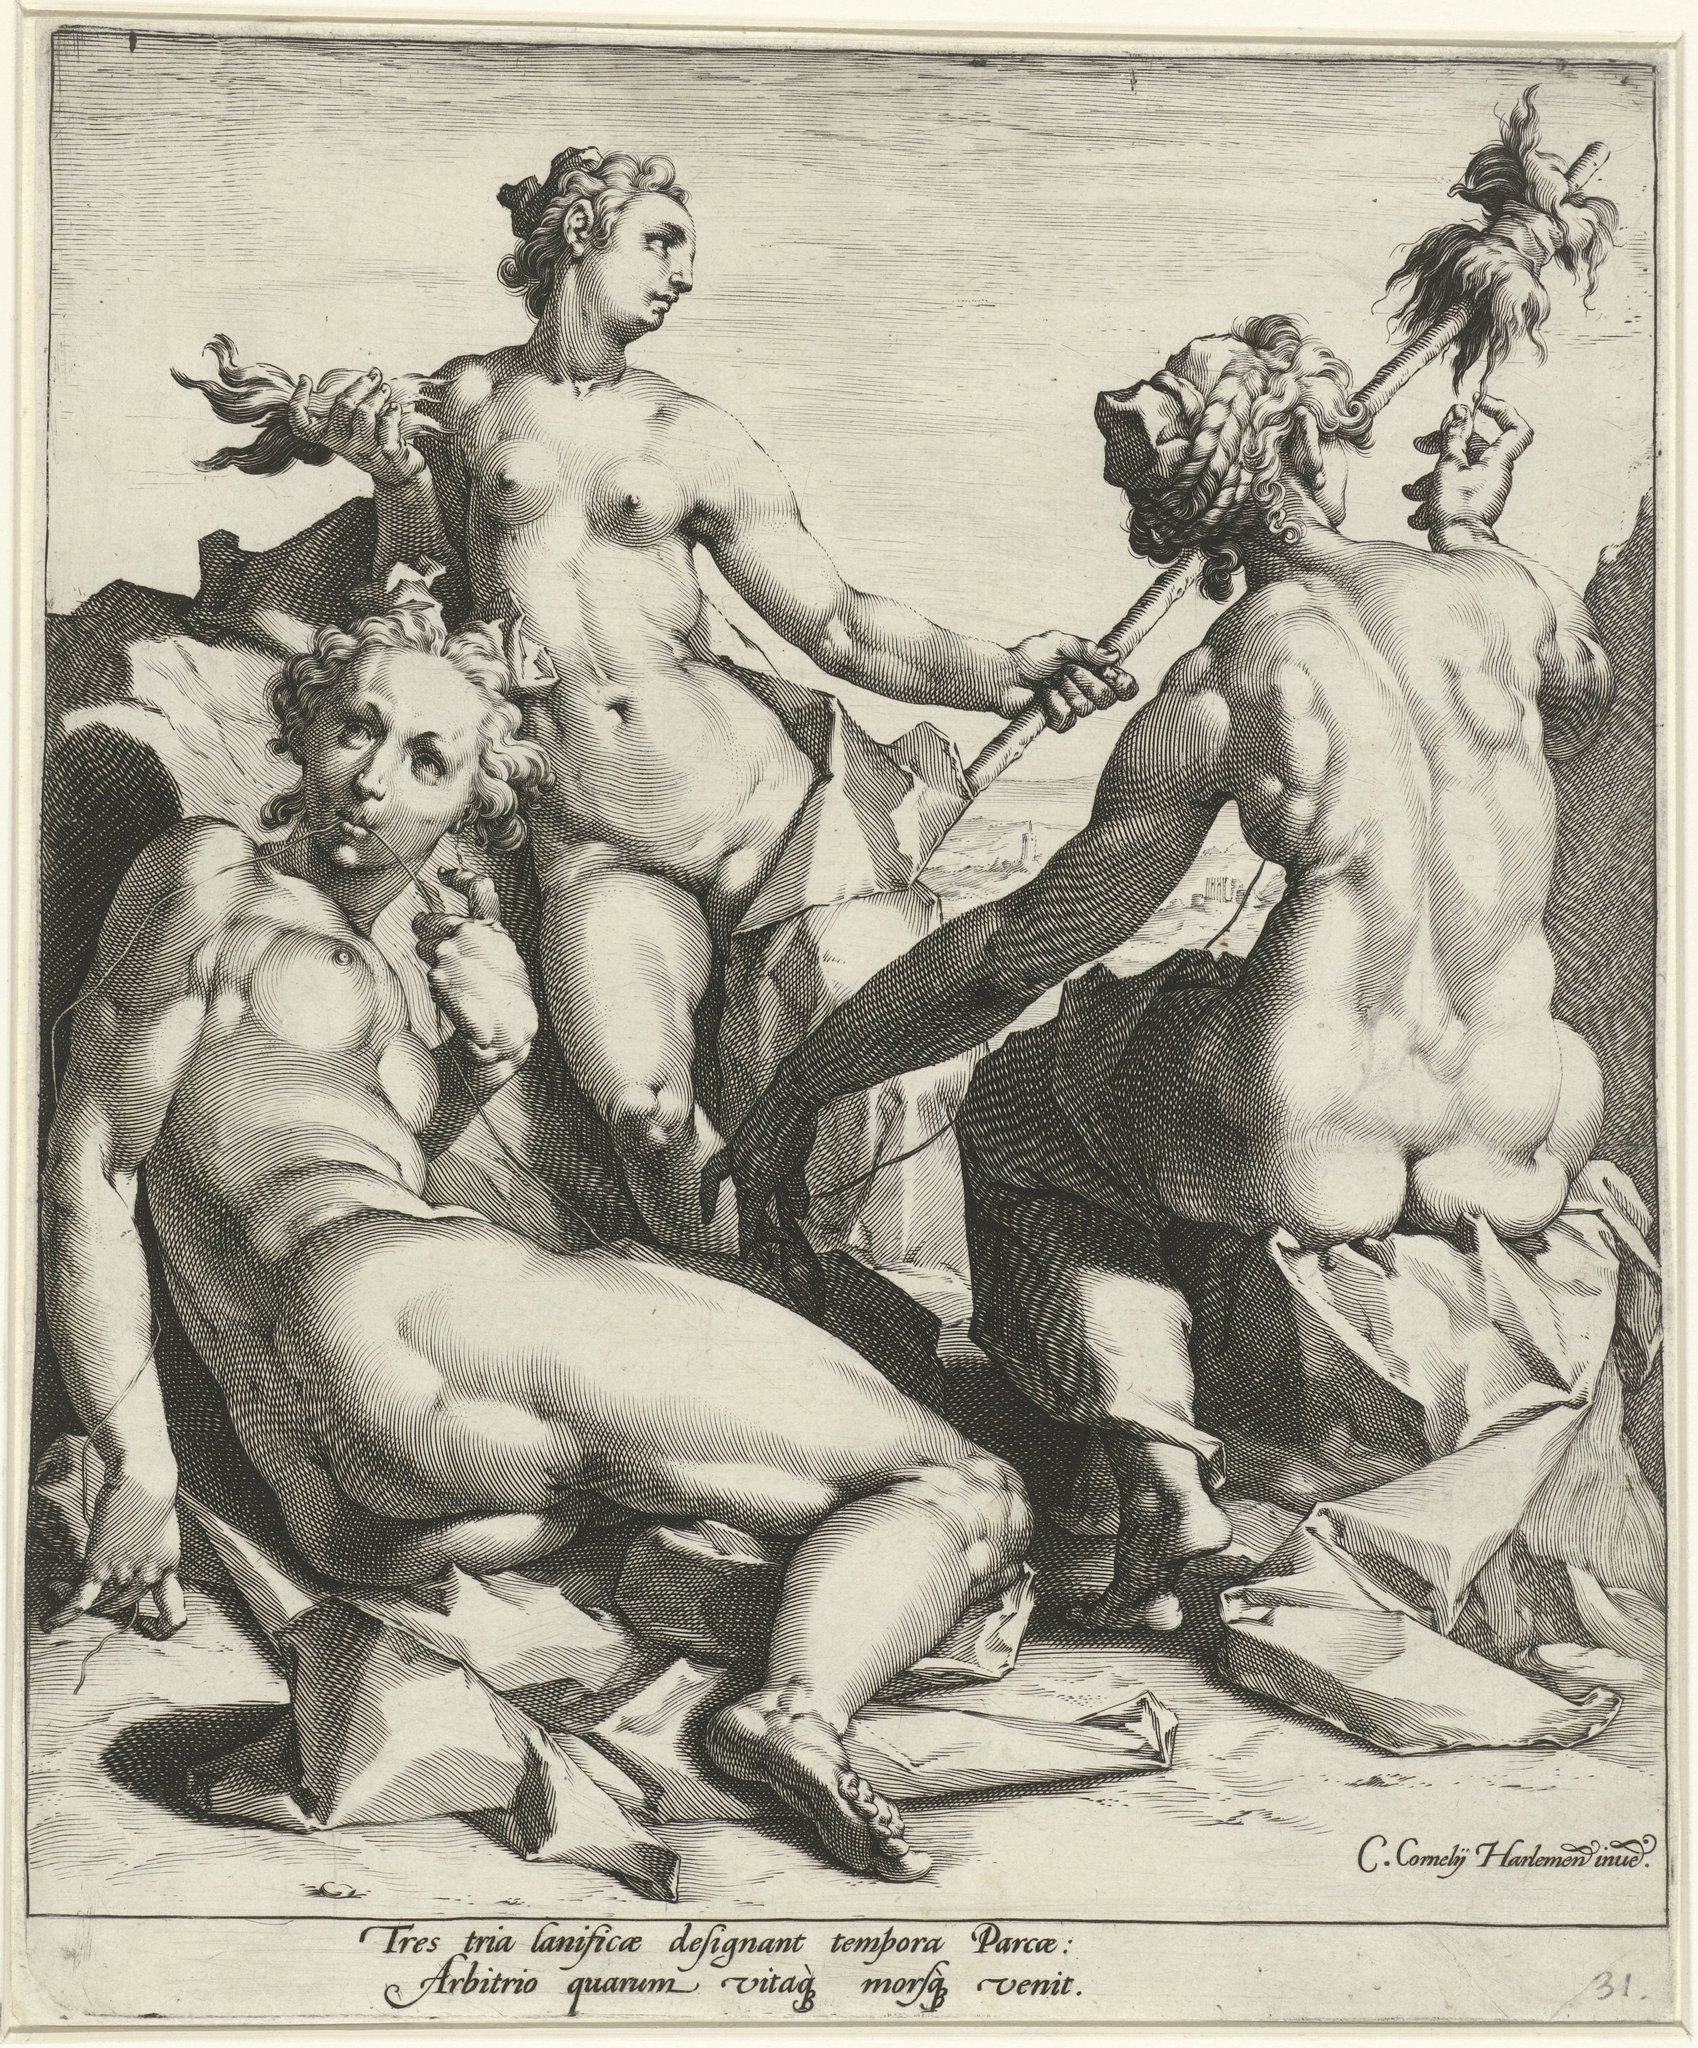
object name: print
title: Drie schikgodinnen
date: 1587-1591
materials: paper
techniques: engraving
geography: amsterdam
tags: fates, parcae (moirae)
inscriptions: collector's mark: Lugt 240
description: De drie schikgodinnen spinnen de levensdraad en bepalen de lengte en het einde van de draad. Clotho houdt in het midden de spinrok vast, Lachesis spint de draad en Atropos bijt met haar tanden de draad door. Onderaan in de marge twee regels in het Latijn.